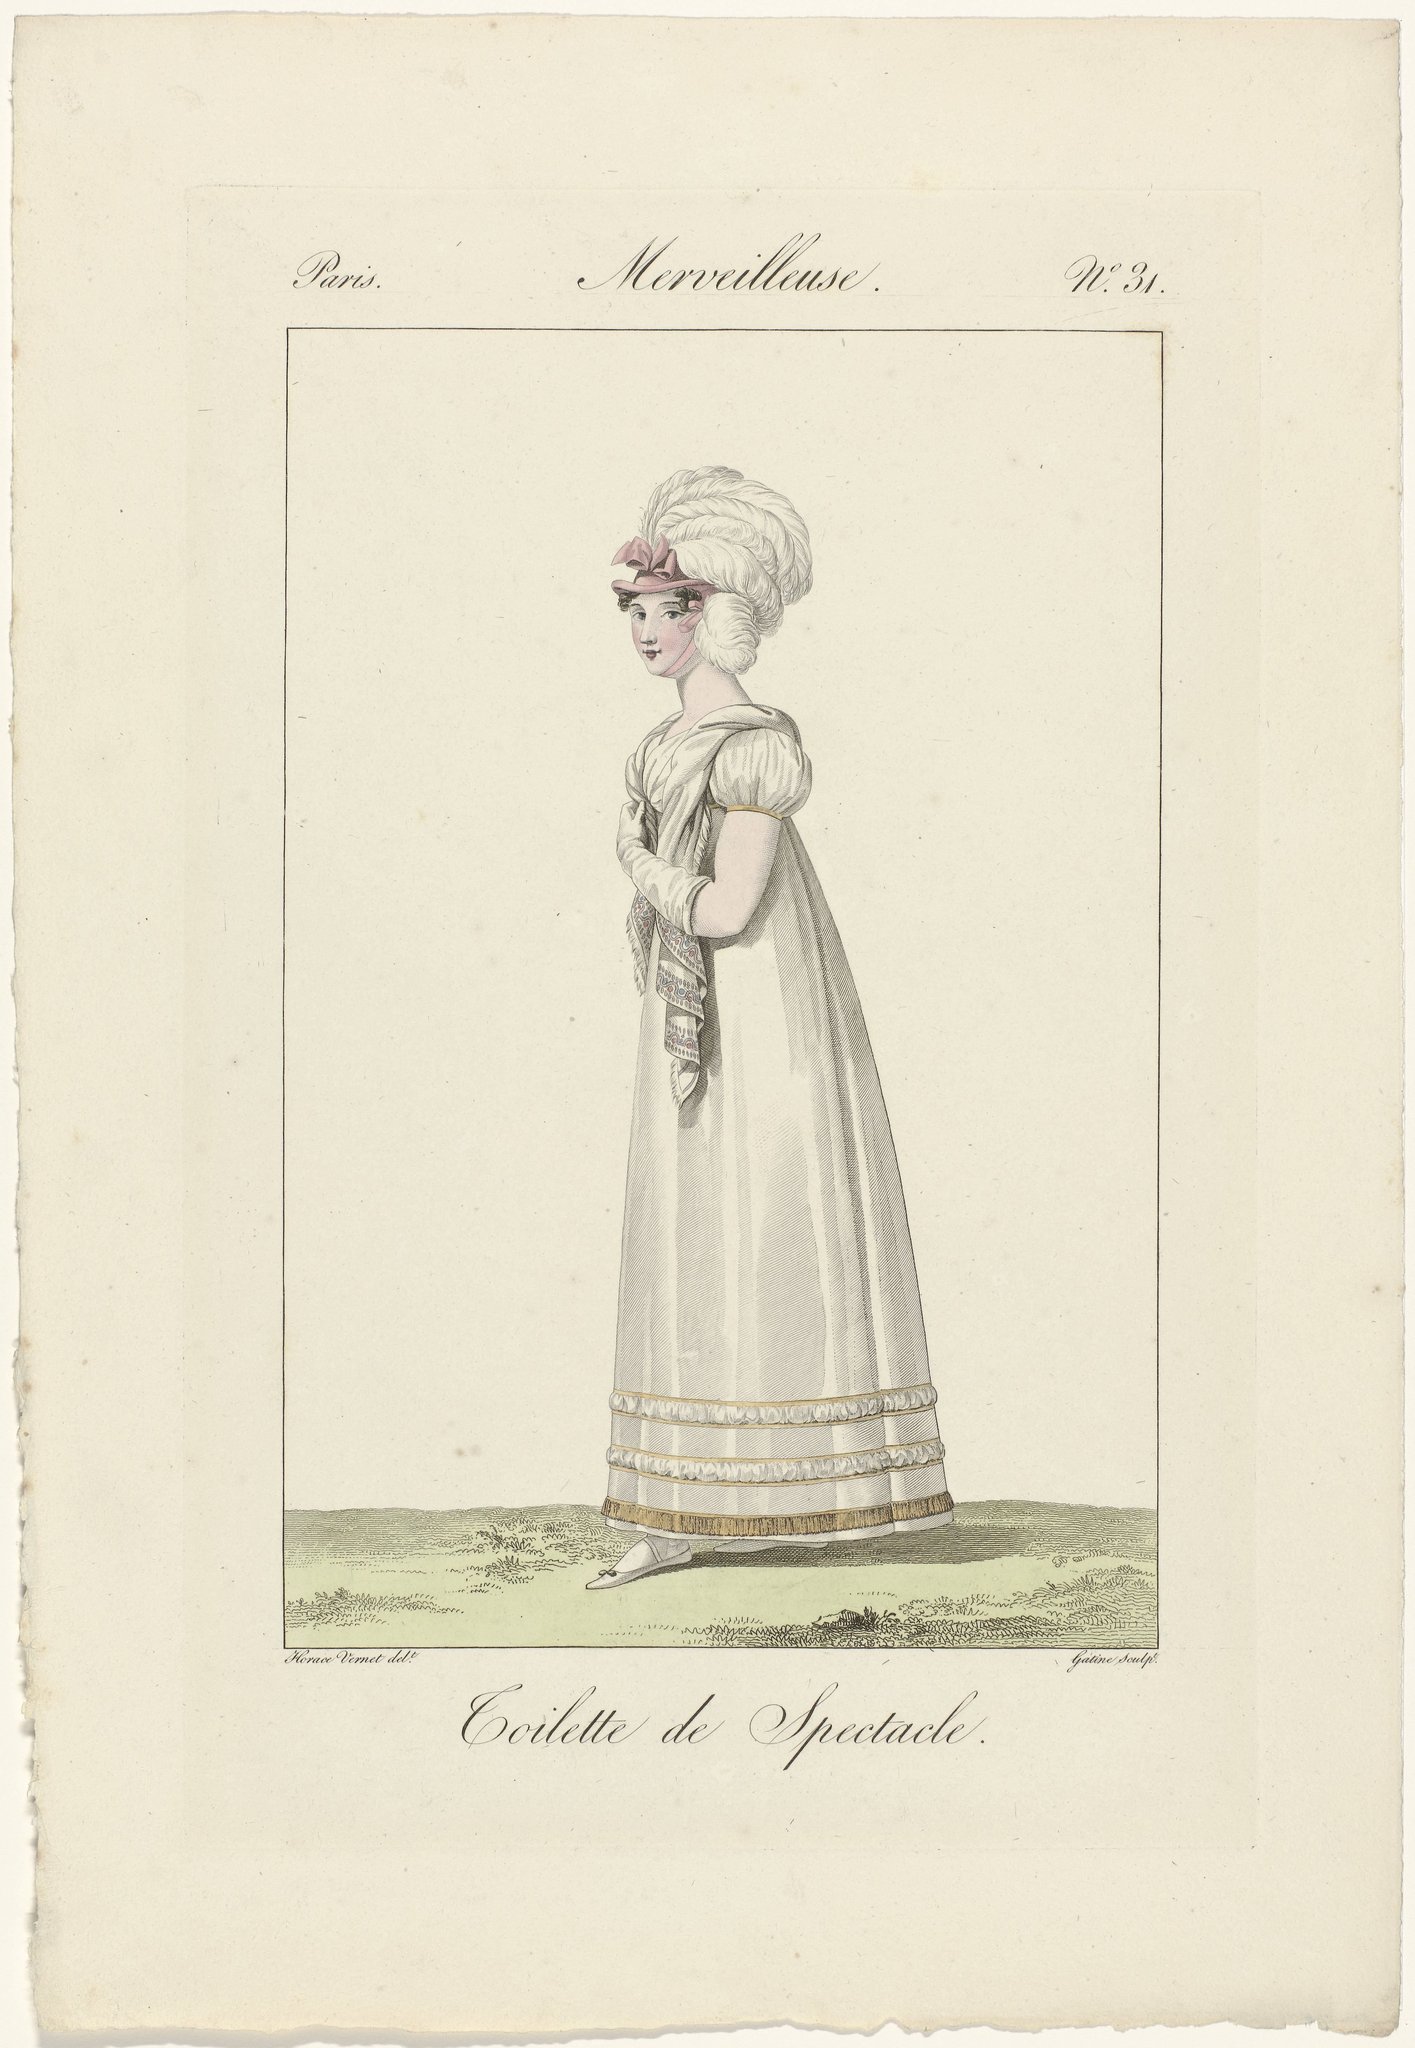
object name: fashion print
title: Incroyables et Merveilleuses, 1817, Merveilleuse, No. 31: Toilette de Spectacle.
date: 1817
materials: paper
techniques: engraving, hand coloring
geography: paris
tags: gloves, mittens (long gloves) (+ women's clothes), clothing for the upper part of the body (shawl) (+ women's clothes), 'merveilleuse', fashion plates, head-gear: hat (+ women's clothes), shoes, sandals (+ women's clothes), dress, gown (+ women's clothes)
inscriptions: title: ‘Paris. Merveilleuse. No. 31.’, caption: ‘Toilette de Spectacle.’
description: 'Merveilleuse' in een 'toilette de Spectacle'. Zij draagt een japon met korte pofmouwen, die bij de zoom is versierd met twee banden en franjes. Accessoires: hoed versierd met struisveren, sjaal met aan de uiteinden franjes, lange handschoen, platte schoenen met strik en band over de wreef. De prent maakt deel uit van een serie van 33 modeprenten, gegraveerd door George Jacques Gatine, Parijs, 1810-1818.